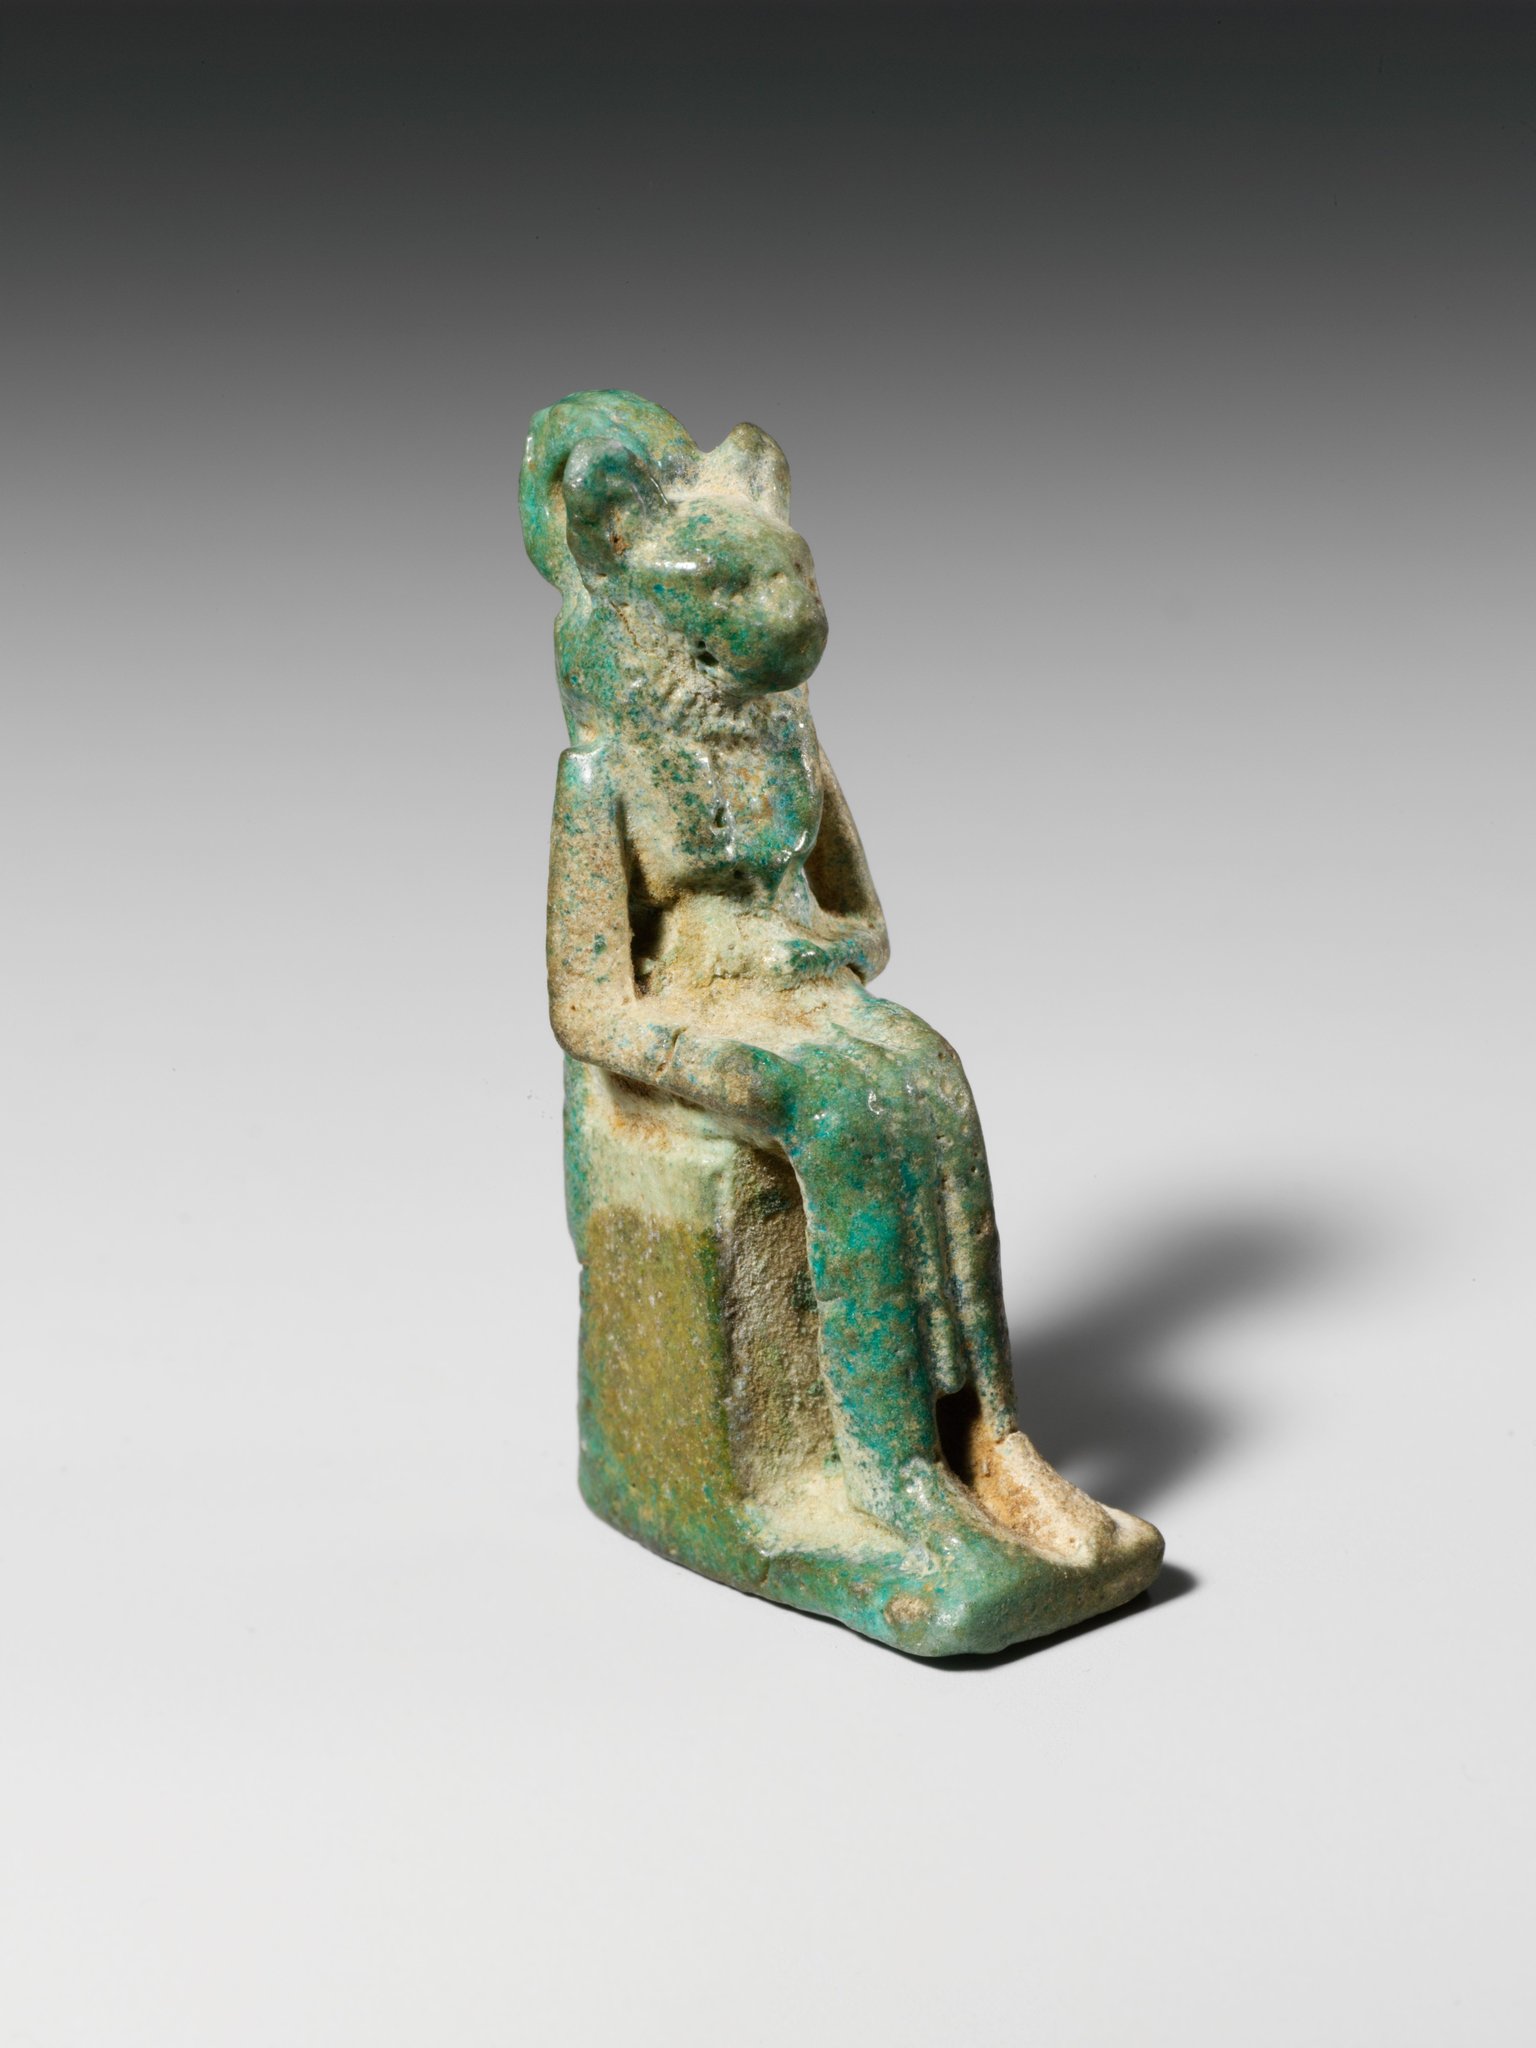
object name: amulet, bast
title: Faience amulet of a goddess with feline head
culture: egyptian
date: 664-630 BCE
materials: faience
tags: lions